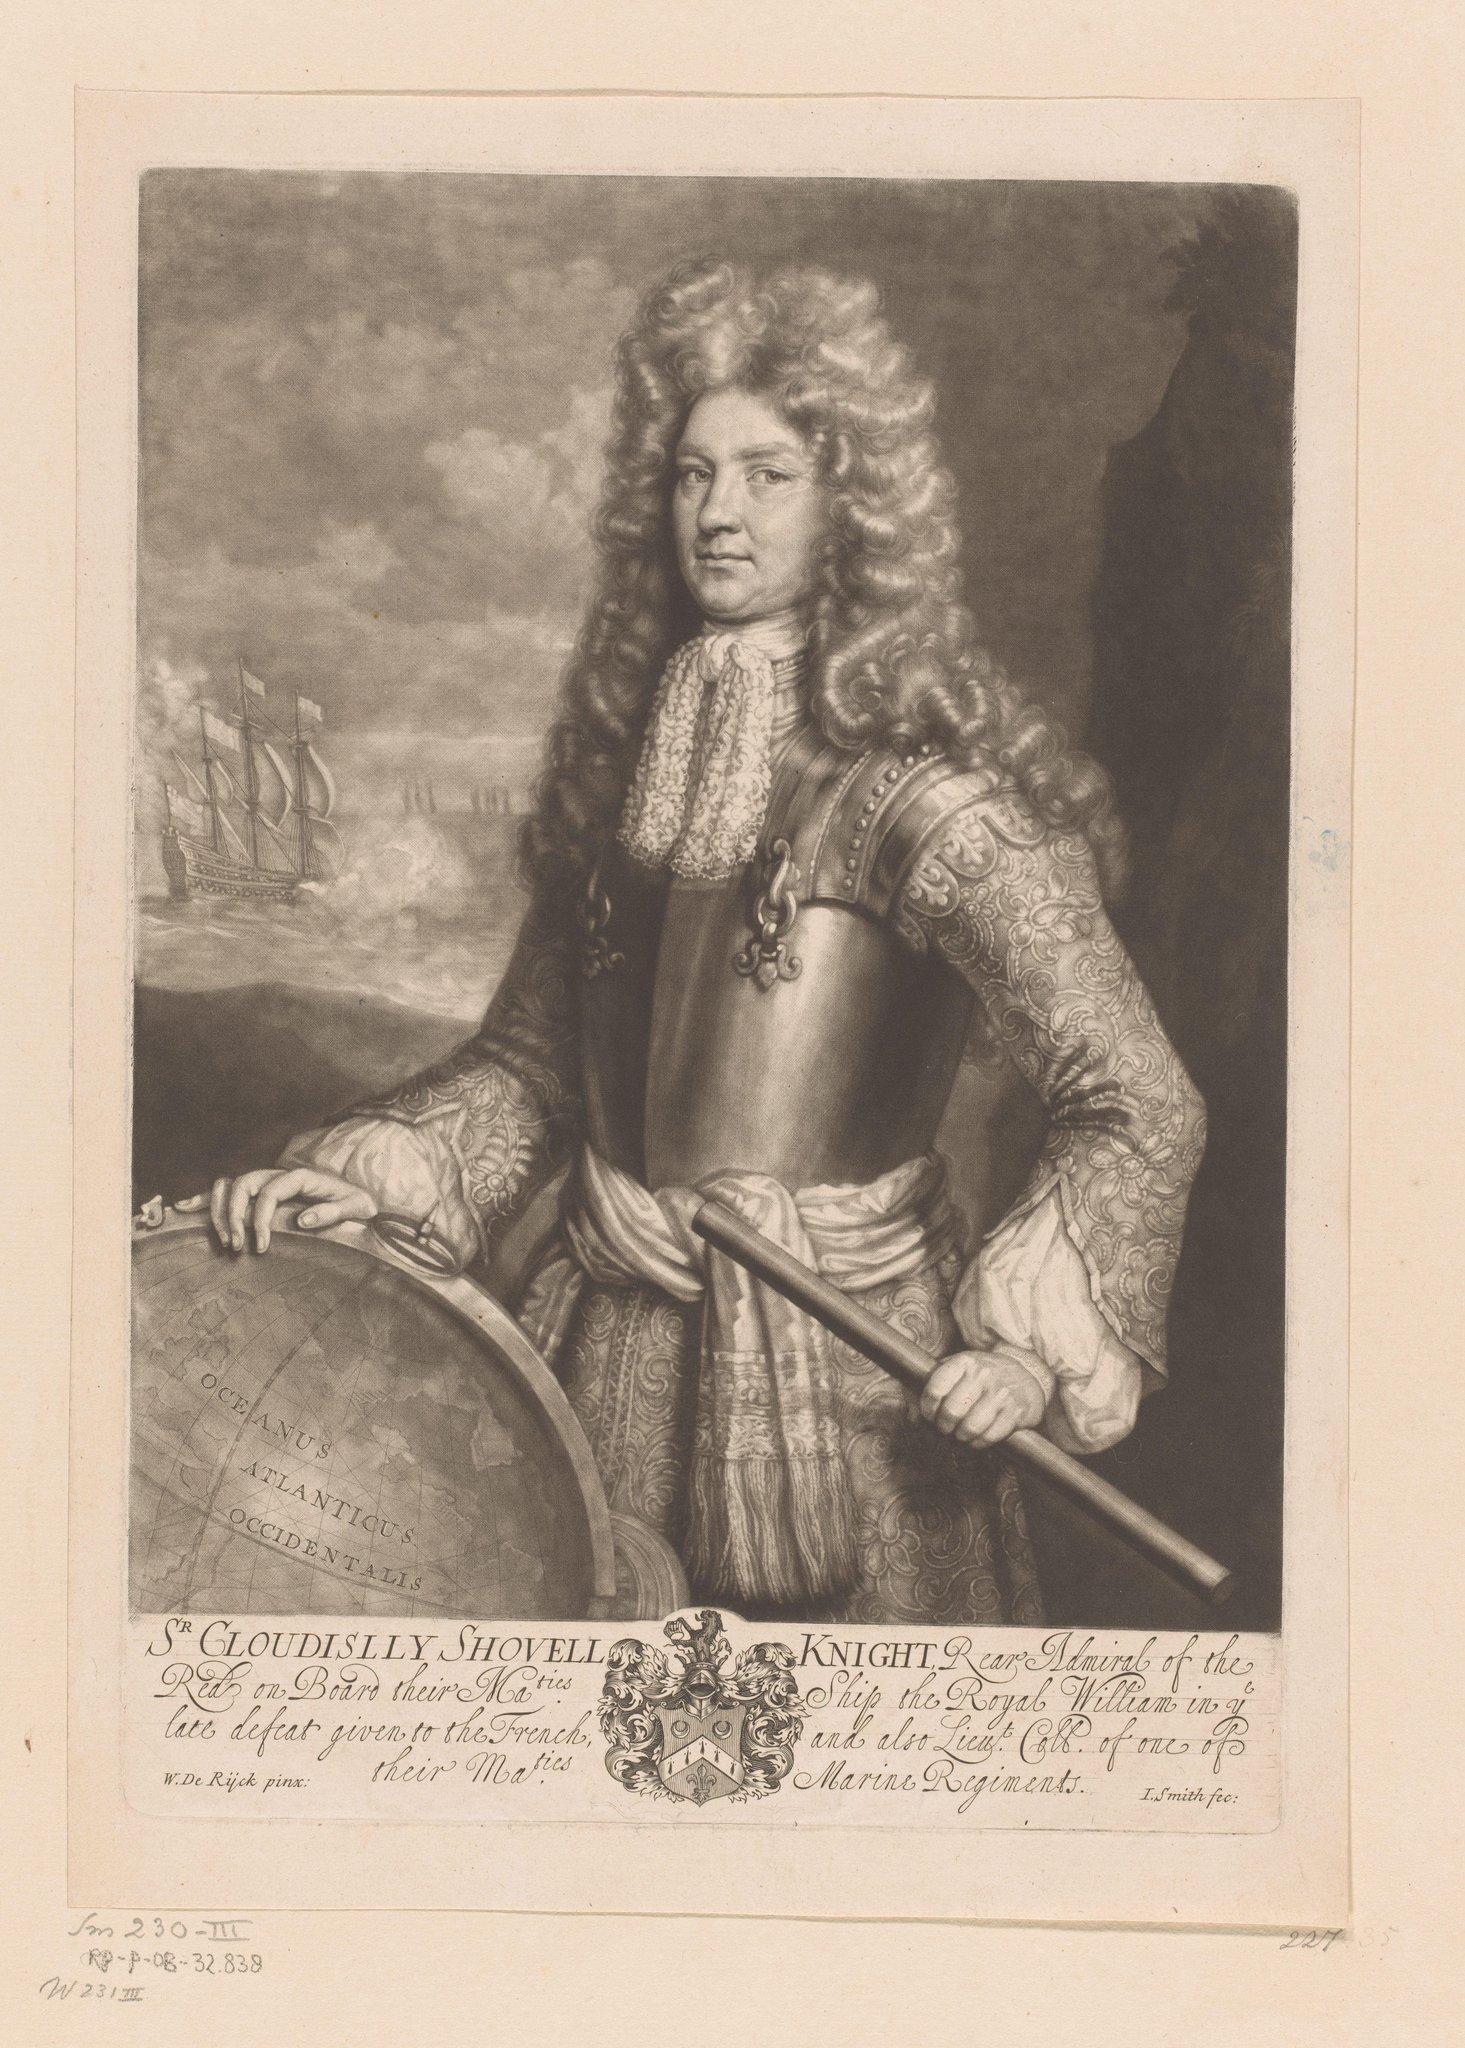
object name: print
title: Sir Cloudislly Shovell Knight (...)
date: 1662-1742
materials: paper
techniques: mezzotint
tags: historical persons, baton of general, commander-in-chief, admiral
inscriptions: collector's mark: Lugt 240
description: Tekst in het Engels in de ondermarge. Zijn hand ligt op een globe met daarop 'Odeanus Atlanticus Occidentalis'. Een zeeslag achteraan.